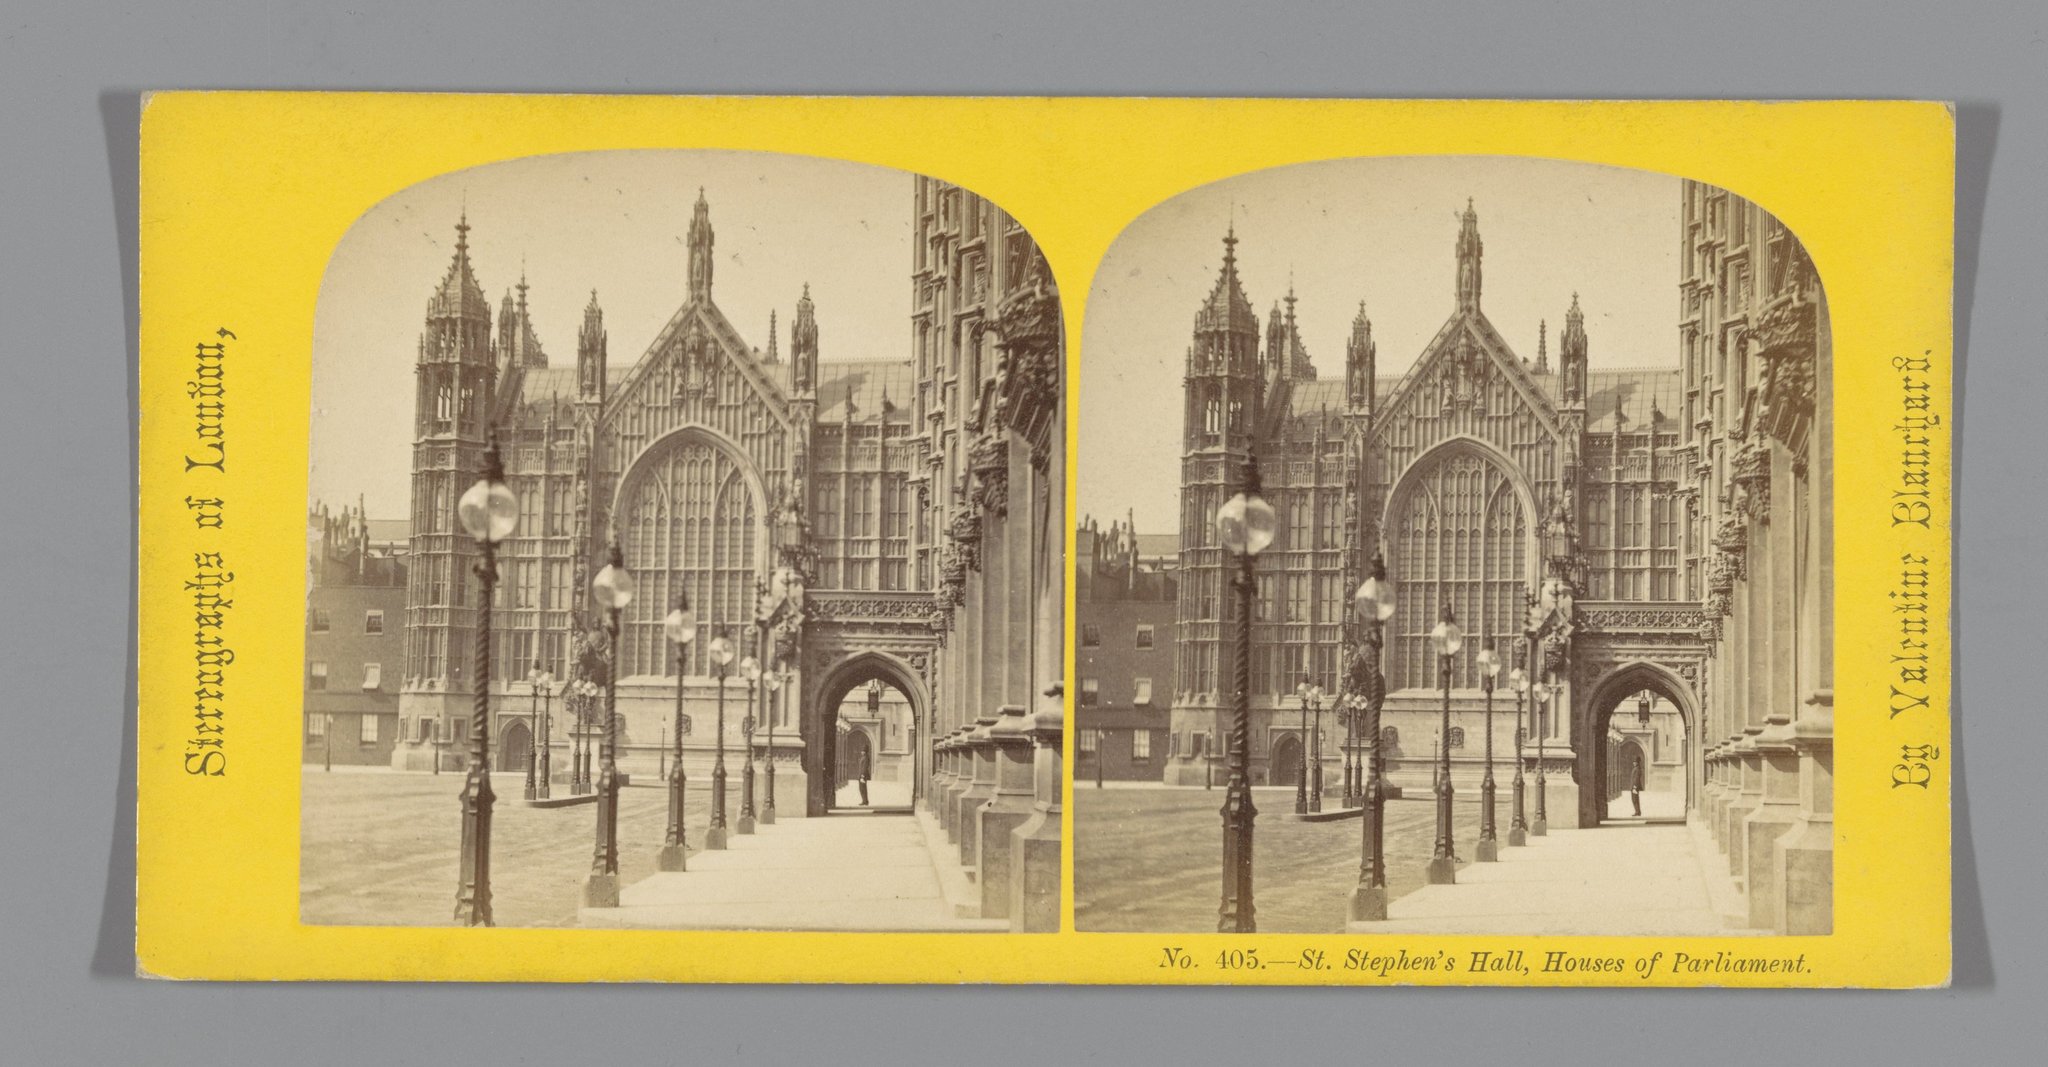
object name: stereograph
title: St. Stephen's Hall, Houses of Parliament.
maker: valentine blanchard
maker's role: fotograaf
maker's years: 1831-1901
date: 1850-1880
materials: cardboard, photographic support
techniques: albumen print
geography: london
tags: façade (of house or building), lower house, parliament, chamber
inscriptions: number: ‘No. 405.’, inscription: ‘Stereographs of London, By Valentine Blanchard.’